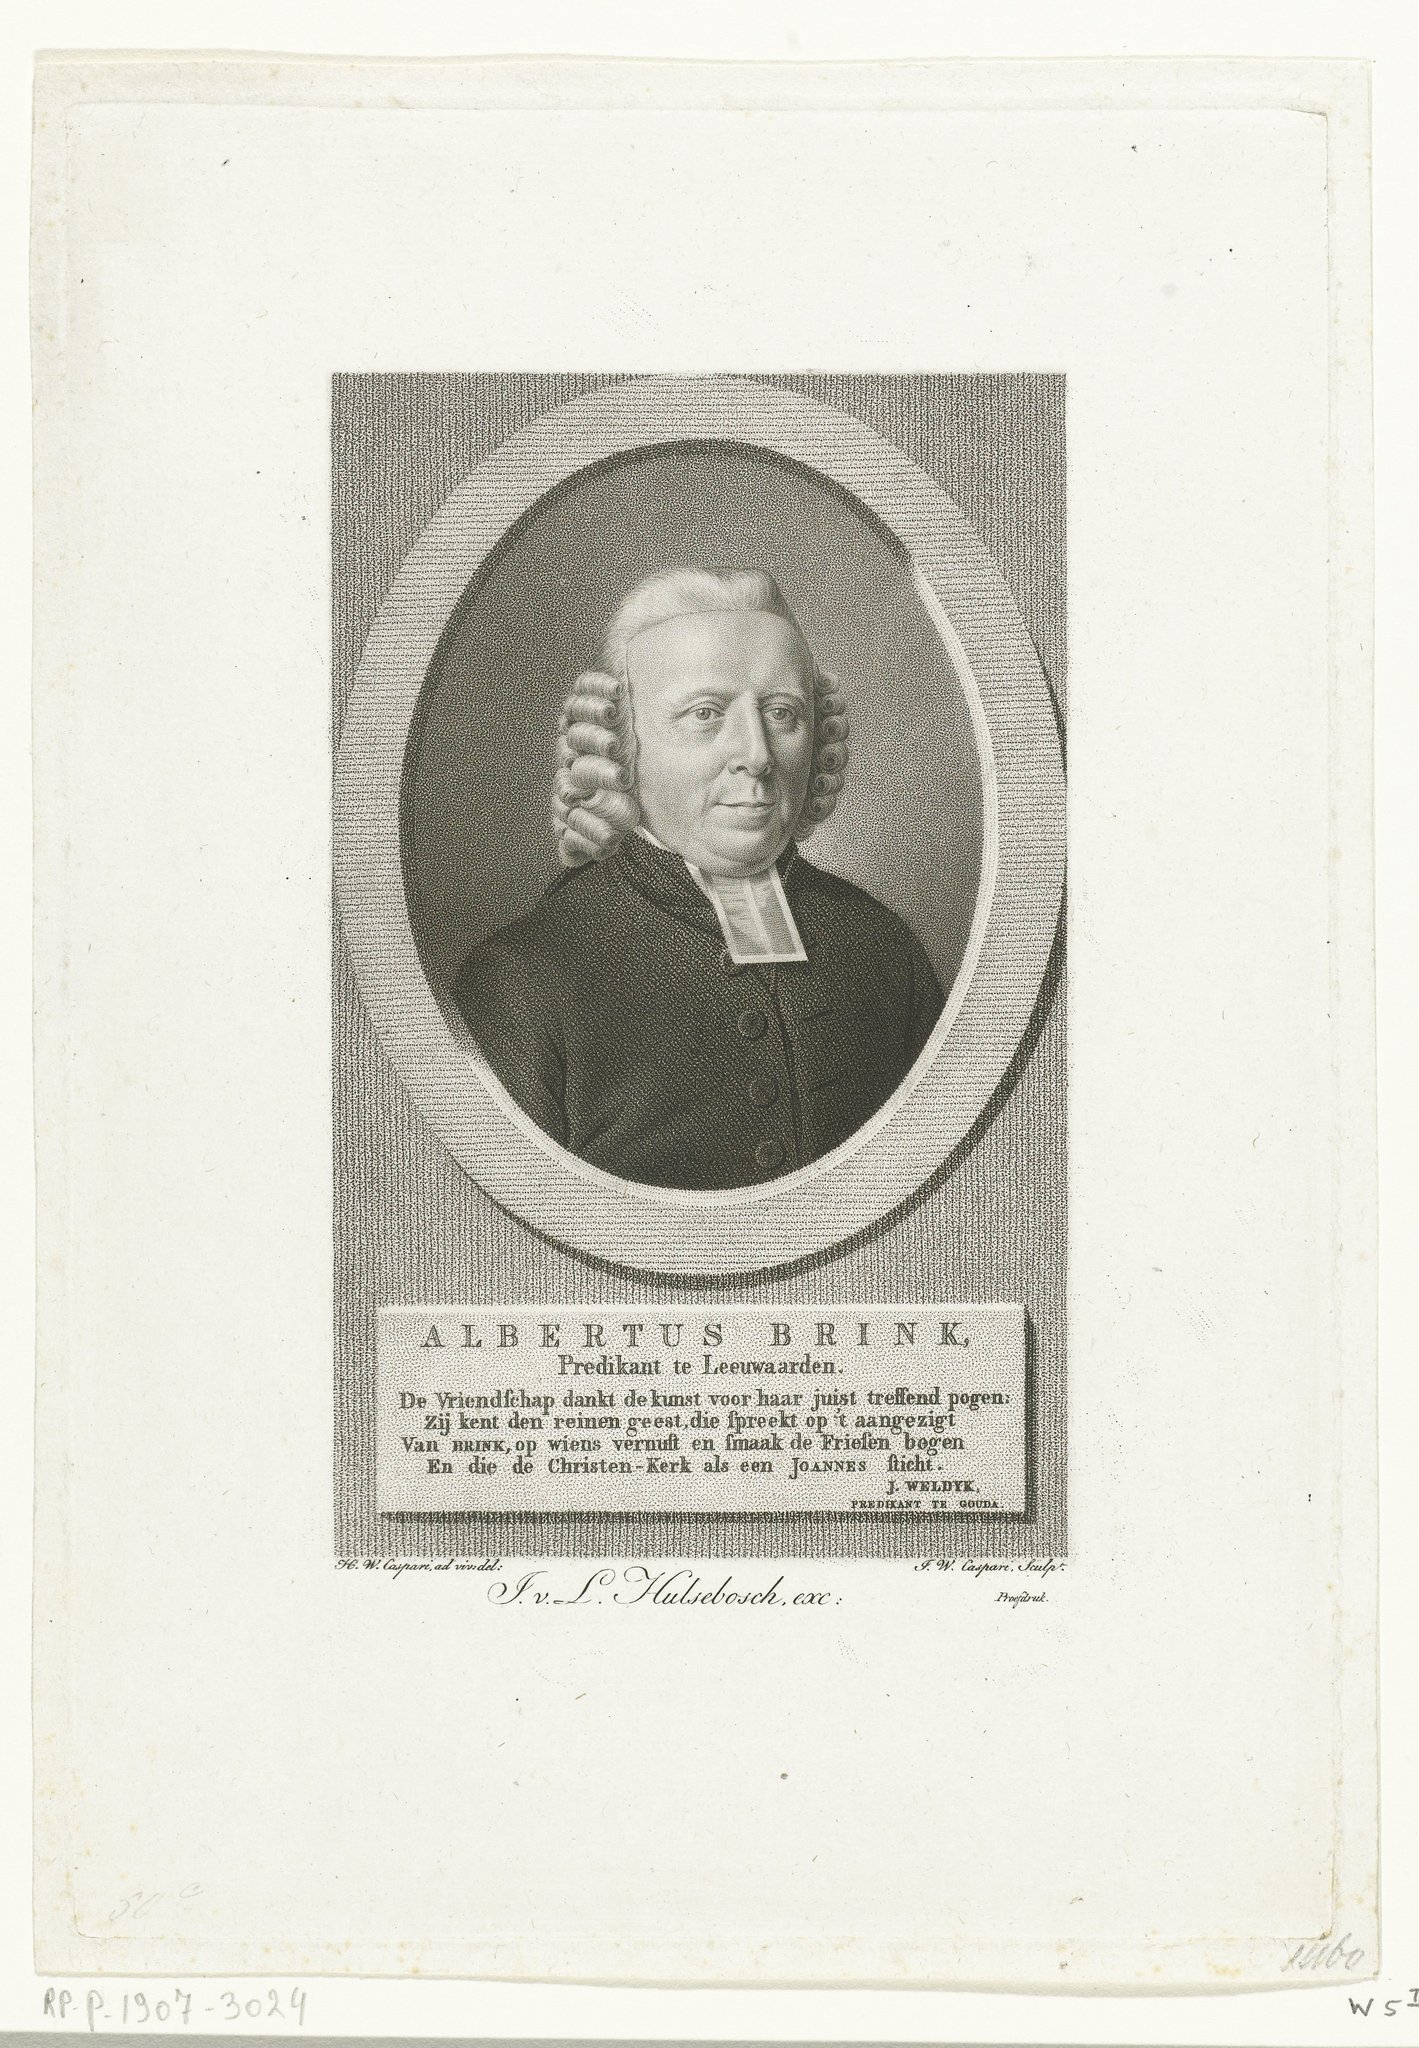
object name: print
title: Portret van Albertus Brink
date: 1789-1822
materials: paper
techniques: etching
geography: gouda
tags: prediker, albertus brink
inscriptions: collector's mark: Lugt 2166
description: Portret in ovale lijst van Albertus Brink, een predikant uit Leeuwarden. Buste naar rechts. Hij draagt een predikerstoga met een witte bef. De prent heeft een Nederlands opschrift met de naam van de geportretteerde en een gedicht.